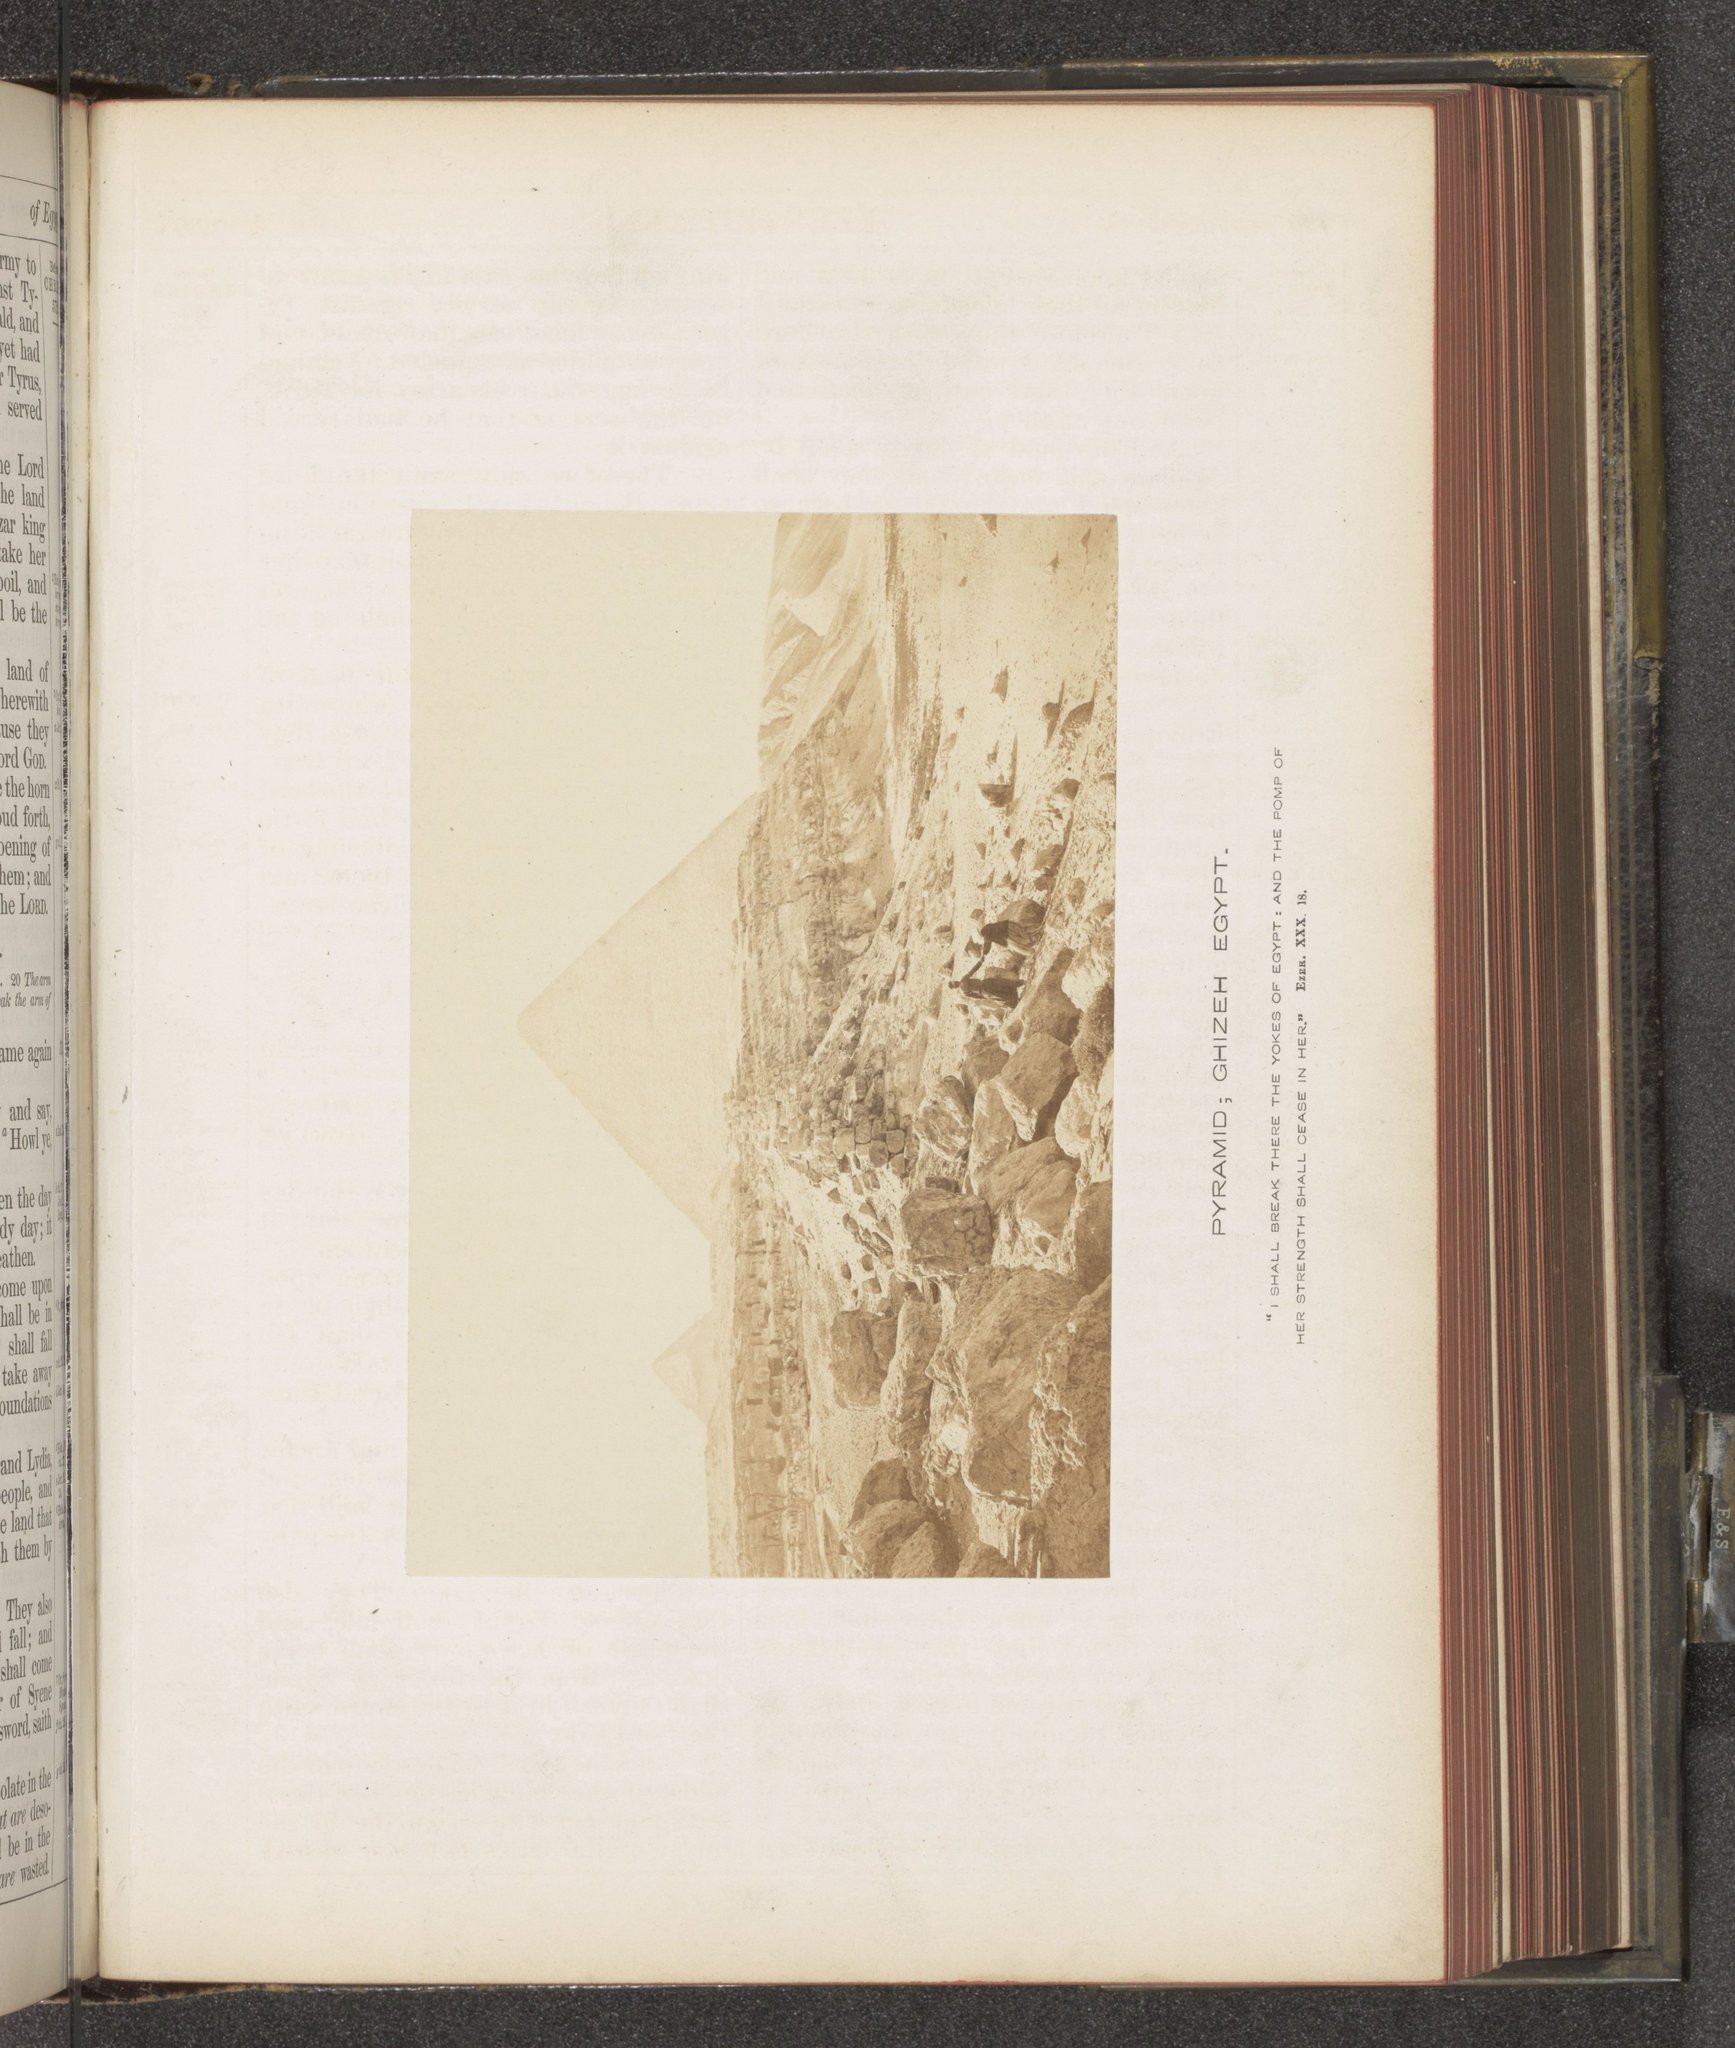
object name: page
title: Gezicht op de Piramide van Cheops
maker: francis frith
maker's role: publisher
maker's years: 1822-1898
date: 1850-1865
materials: photographic support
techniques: albumen print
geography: gizeh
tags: egyptian pyramids (wonder of the world)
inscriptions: inscription: ‘"I shall break there the yokes of Egypt: and the pomp of her strenght shall cease in here." Ezek. XXX. 18.’